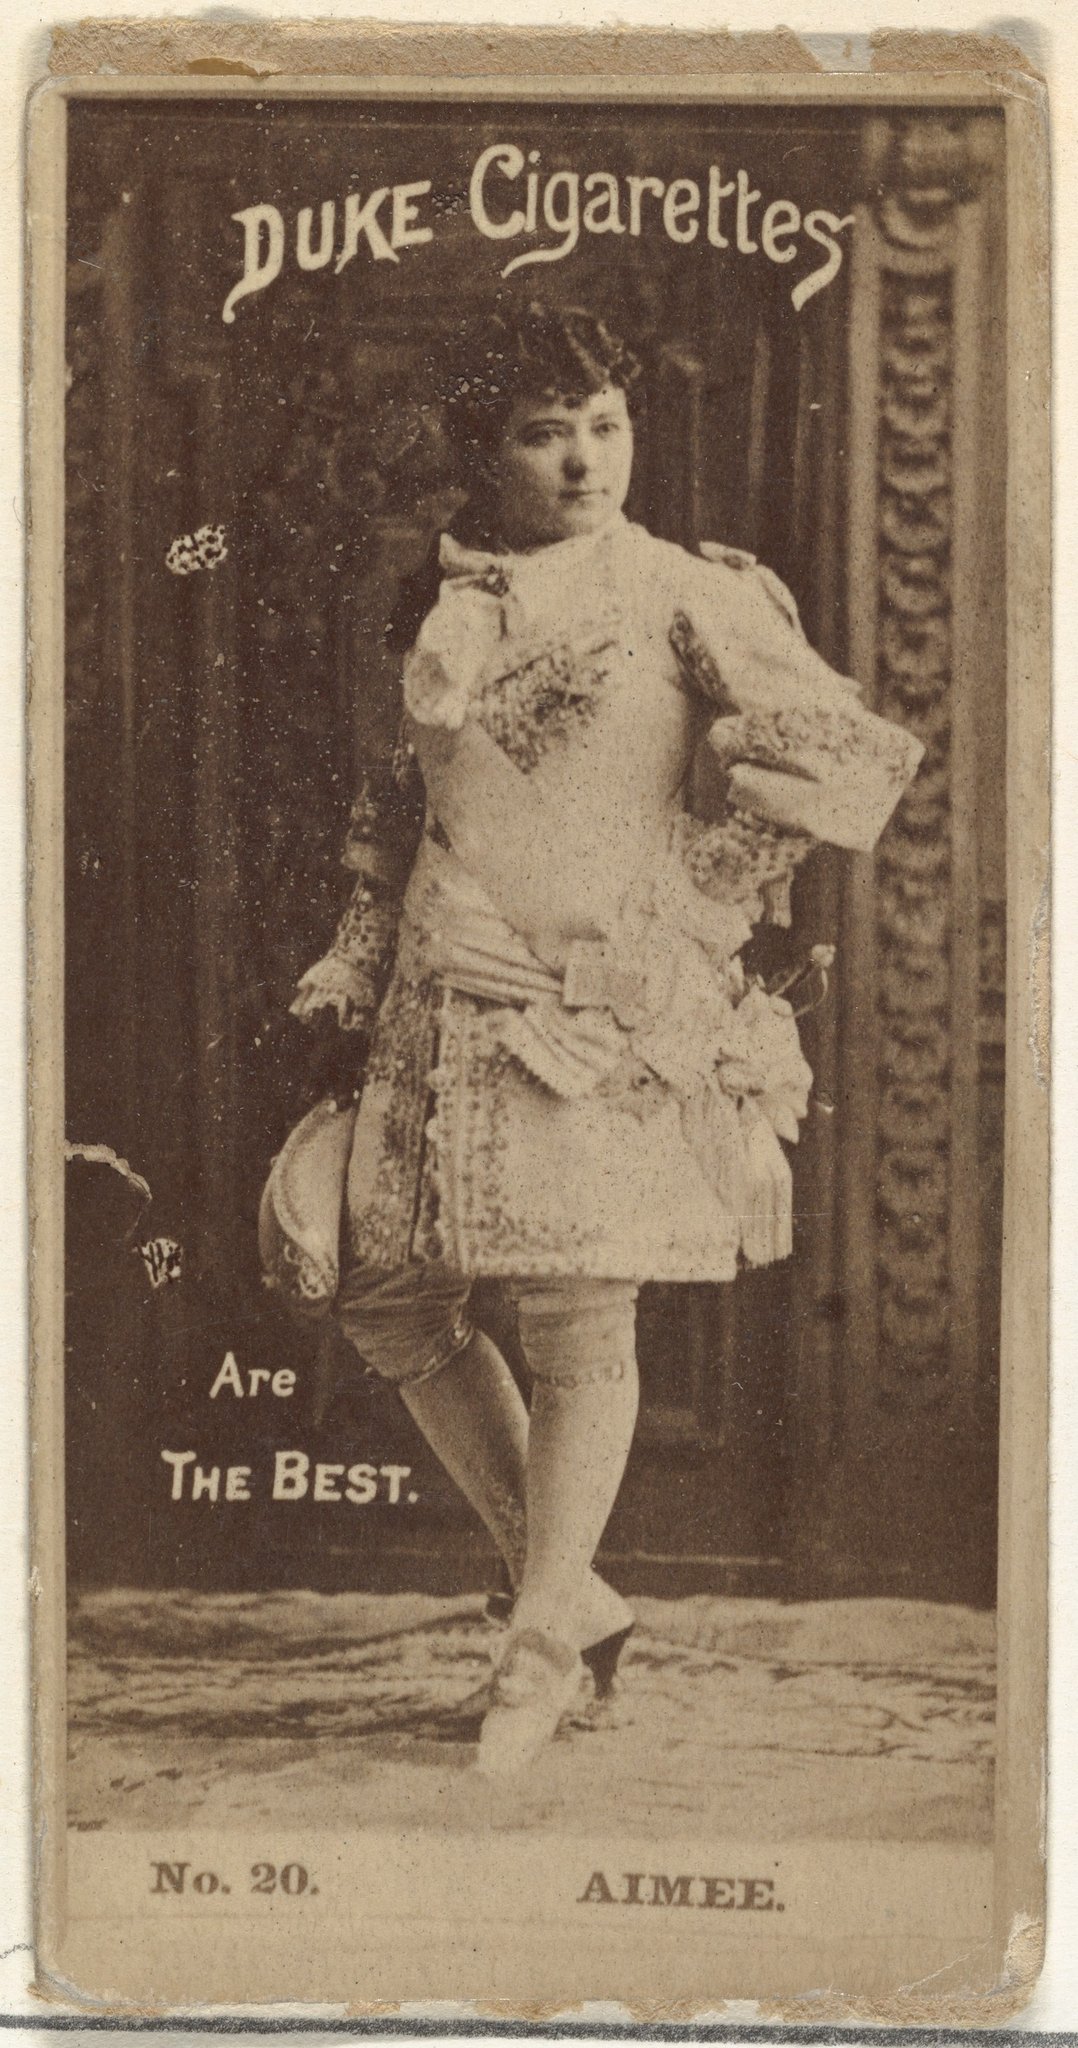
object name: photograph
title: Card Number 20, Aimee, from the Actors and Actresses series (N145-6) issued by Duke Sons & Co. to promote Duke Cigarettes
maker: w. duke, sons & co.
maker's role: publisher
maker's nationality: american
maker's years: 1870-1920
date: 1880-1889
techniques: albumen silver print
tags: portraits,women,actresses